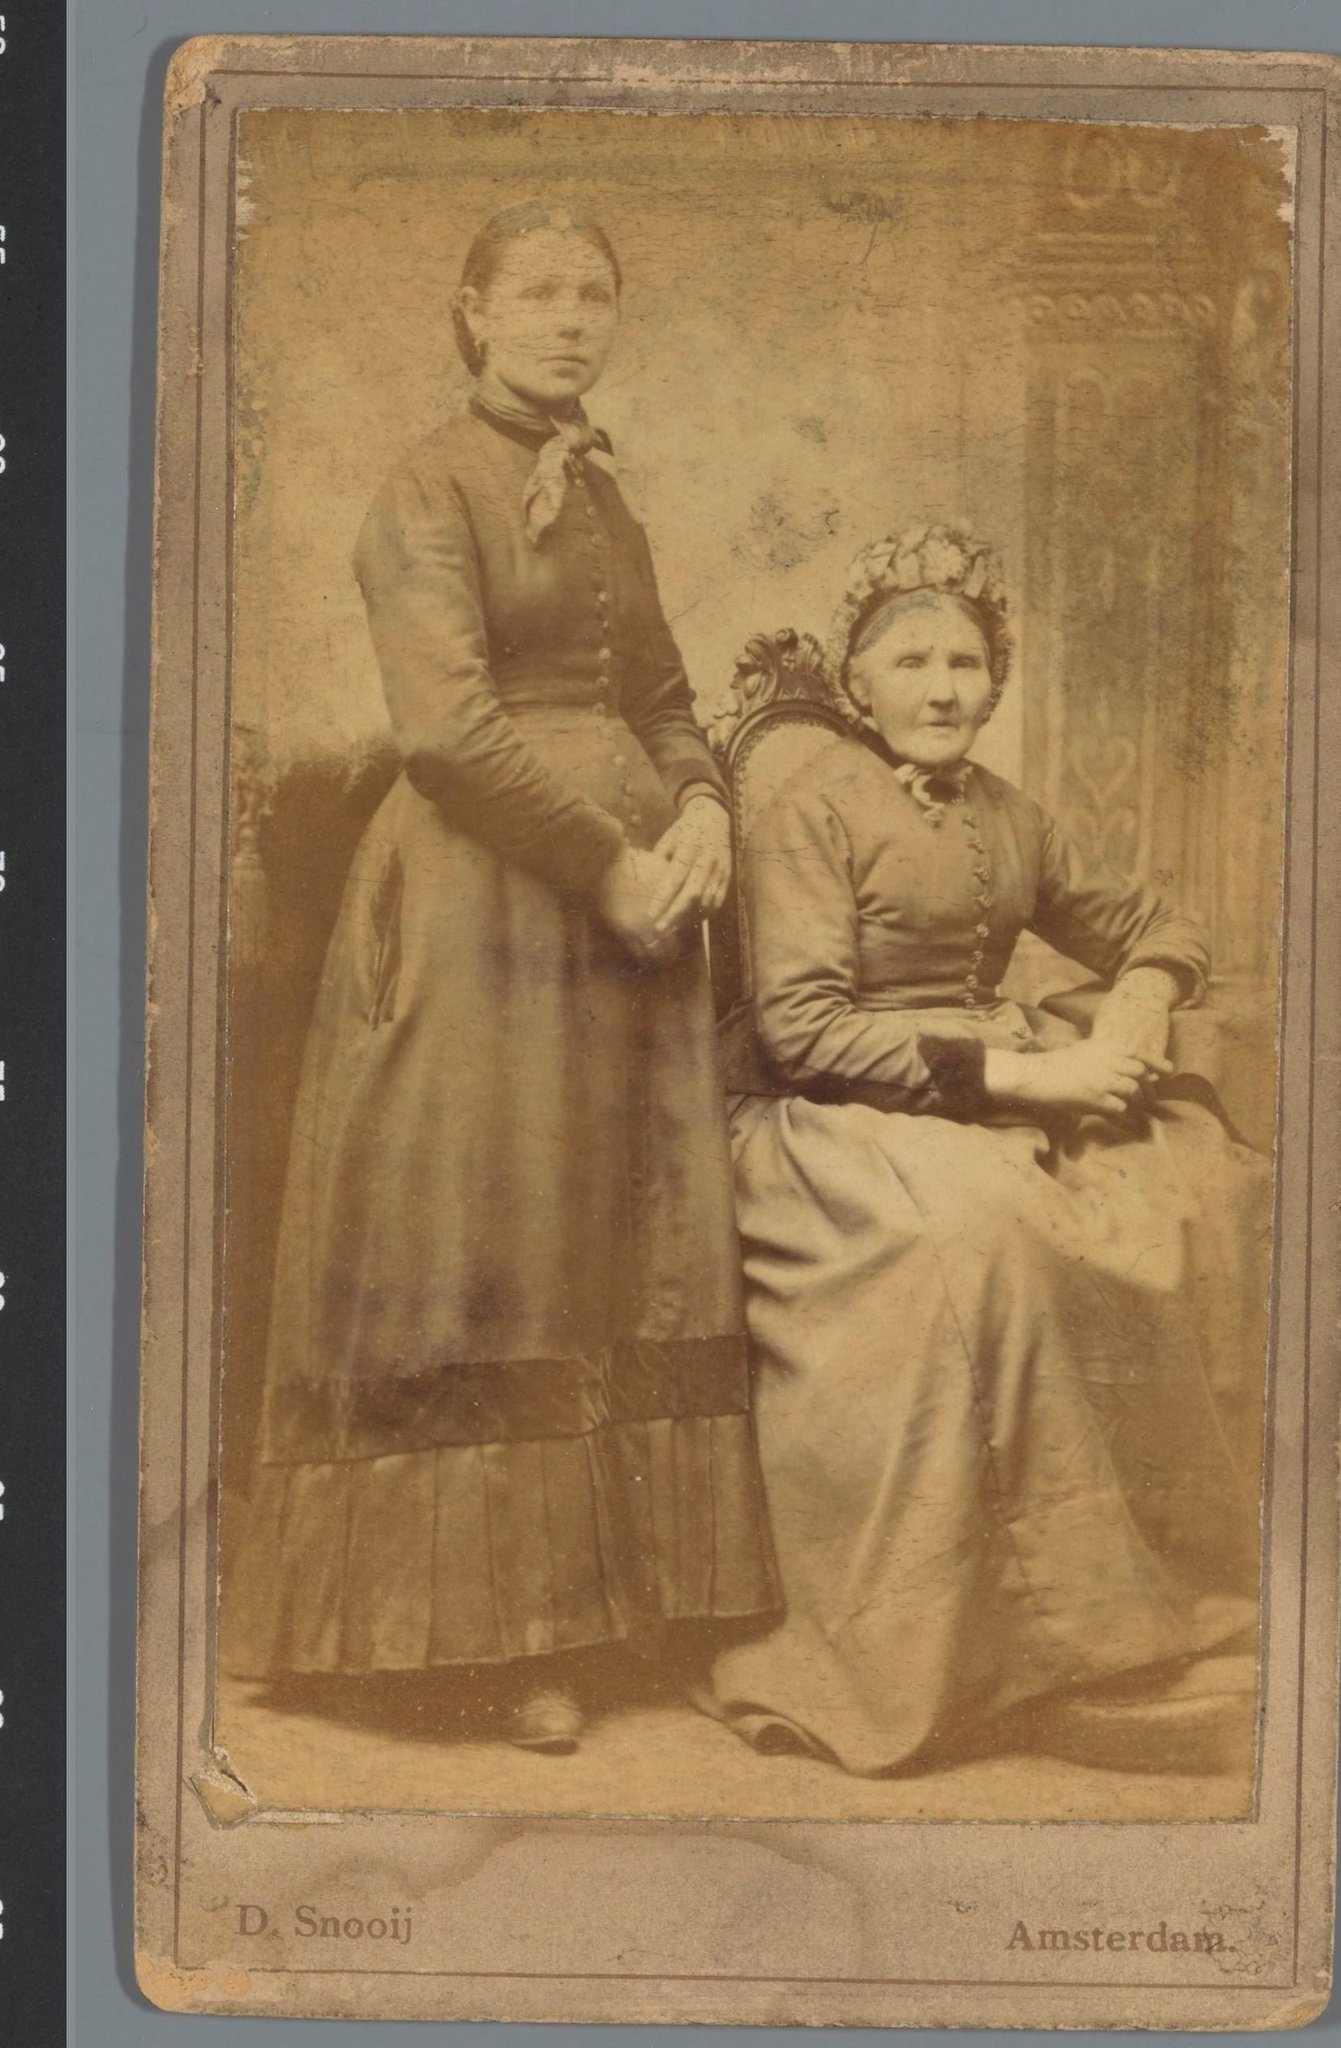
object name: carte de visite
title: Portret van twee onbekende vrouwen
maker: david snooij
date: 1878-1889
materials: cardboard, paper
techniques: albumen print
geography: amsterdam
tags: historical persons, adult woman (+ two persons)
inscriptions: inscription: ‘VOLKSVLIJT/ [...] TIJDSCHRIFT [...]/ LANDBOUW, HANDEL, SCHEEPVAART.’